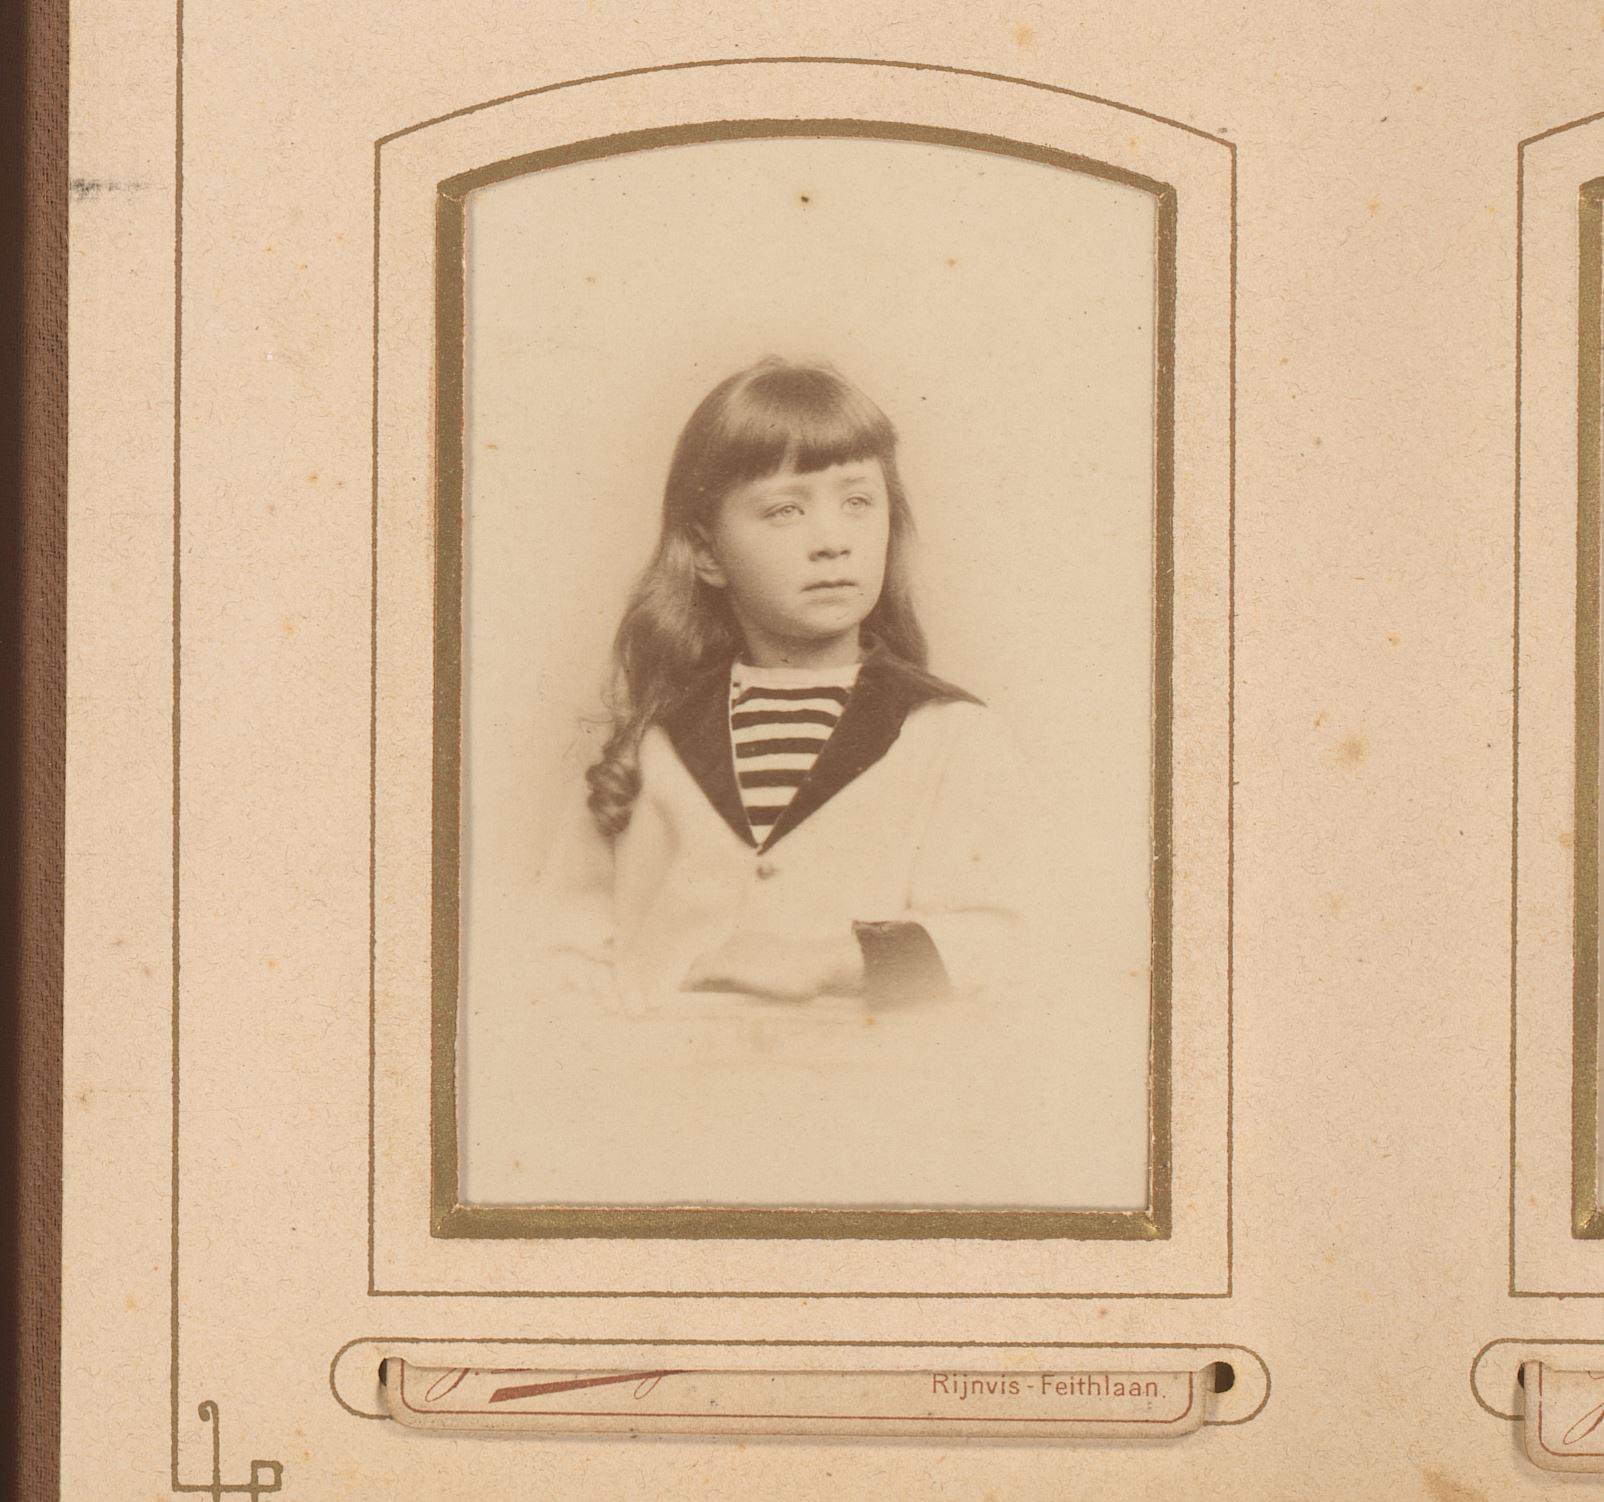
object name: album leaf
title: Portret van een meisje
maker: jacques daniël rijk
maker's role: draughtsman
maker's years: 1855-1912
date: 1888-1894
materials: cardboard, photographic support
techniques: albumen print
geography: zwolle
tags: historical persons - bb - woman, girl (child between toddler and youth)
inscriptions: inscription: ‘J.D. Rijk/ Zwolle/ Rhijnvis - Feithlaan’